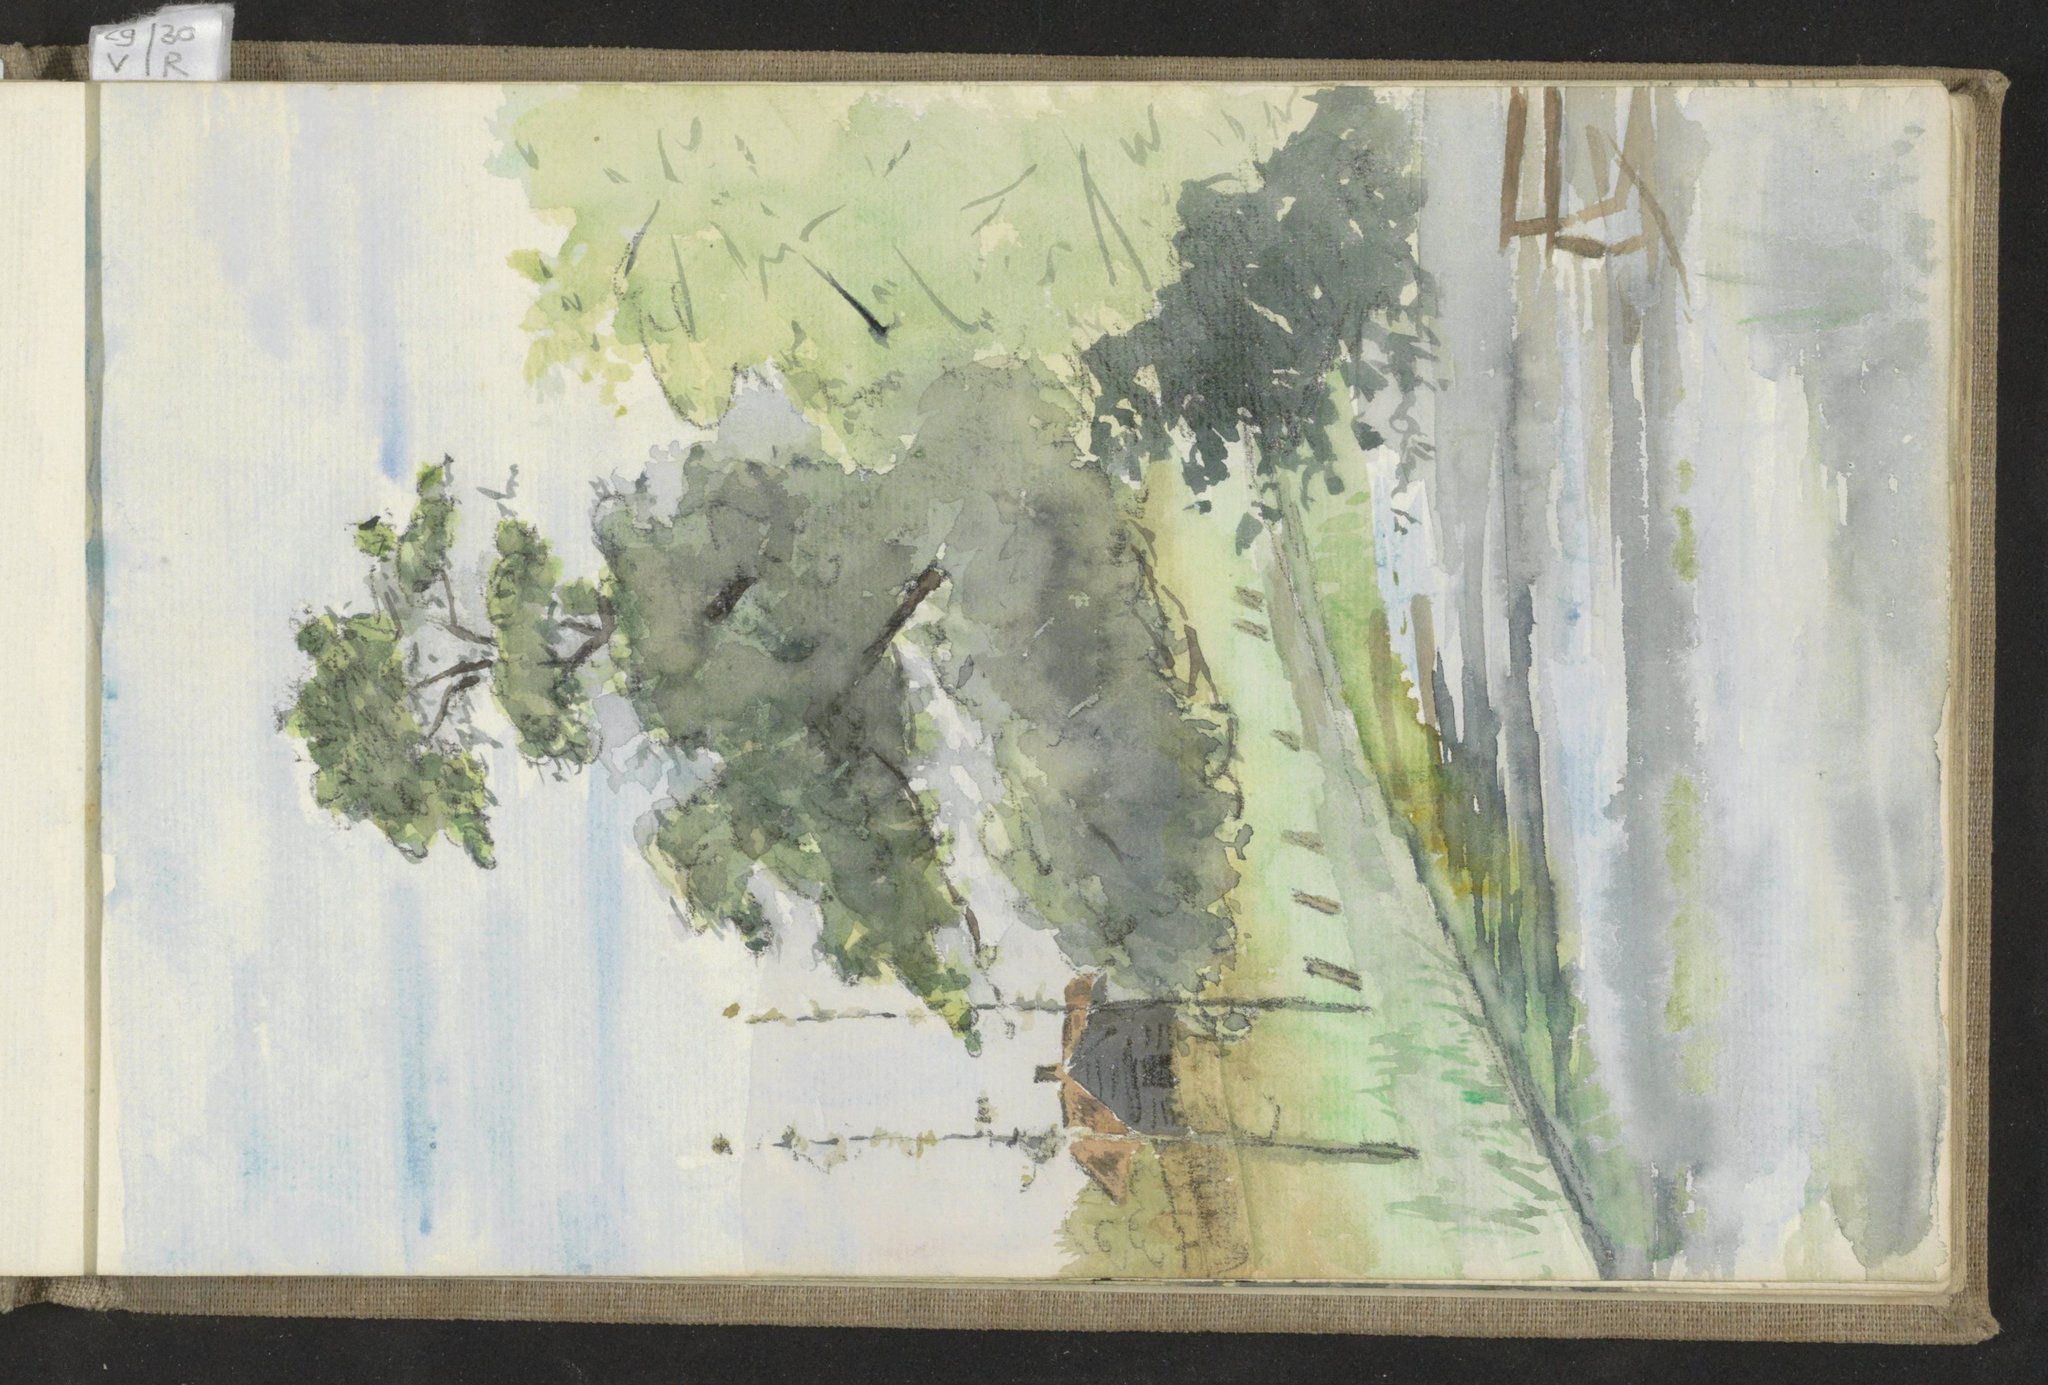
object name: sketchbook leaf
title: Huis bij een waterkant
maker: jonkheer johannes ludovicus paulus bosch van drakestein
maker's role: draughtsman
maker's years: 1865-1929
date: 1896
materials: paper, pencil, watercolor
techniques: brush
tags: landscapes with waters, waterscapes, seascapes (in the temperate zone), farm or solitary house in landscape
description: Blad 25 recto uit een schetsboek met 58 bladen.